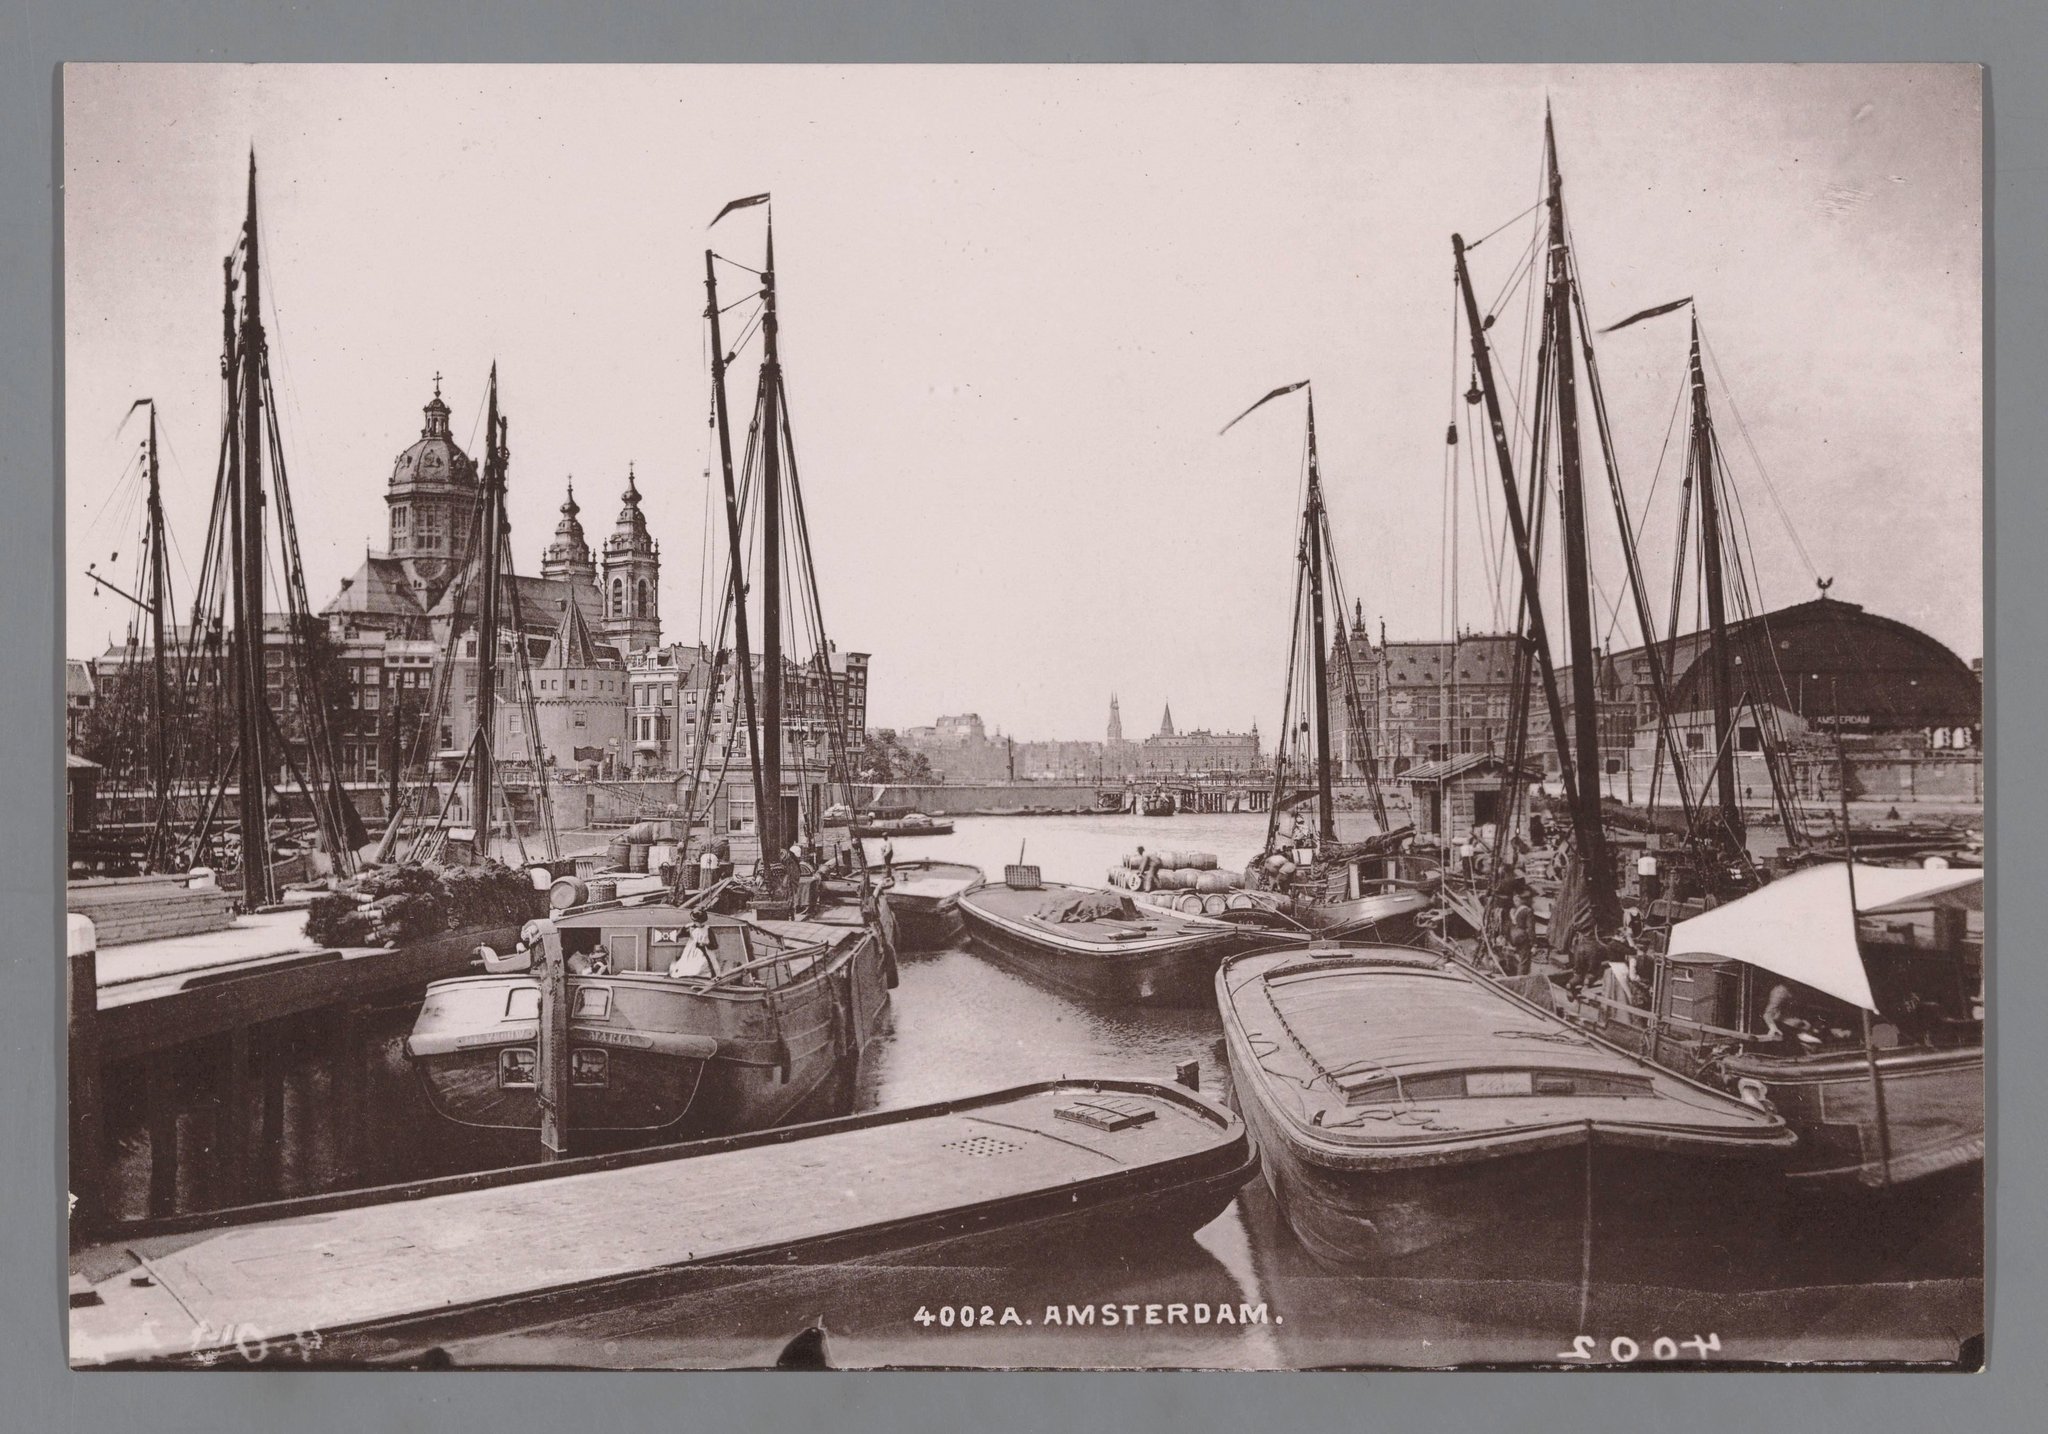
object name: photomechanical print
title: Gezicht op het Oosterdok in Amsterdam, met links de Nicolaaskerk en rechts het Centraal Station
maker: Anonymous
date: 1889-1930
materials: paper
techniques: photograph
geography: amsterdam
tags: harbour, church (exterior), station; shelter (railway, tramway)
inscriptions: number: ‘4002.A’